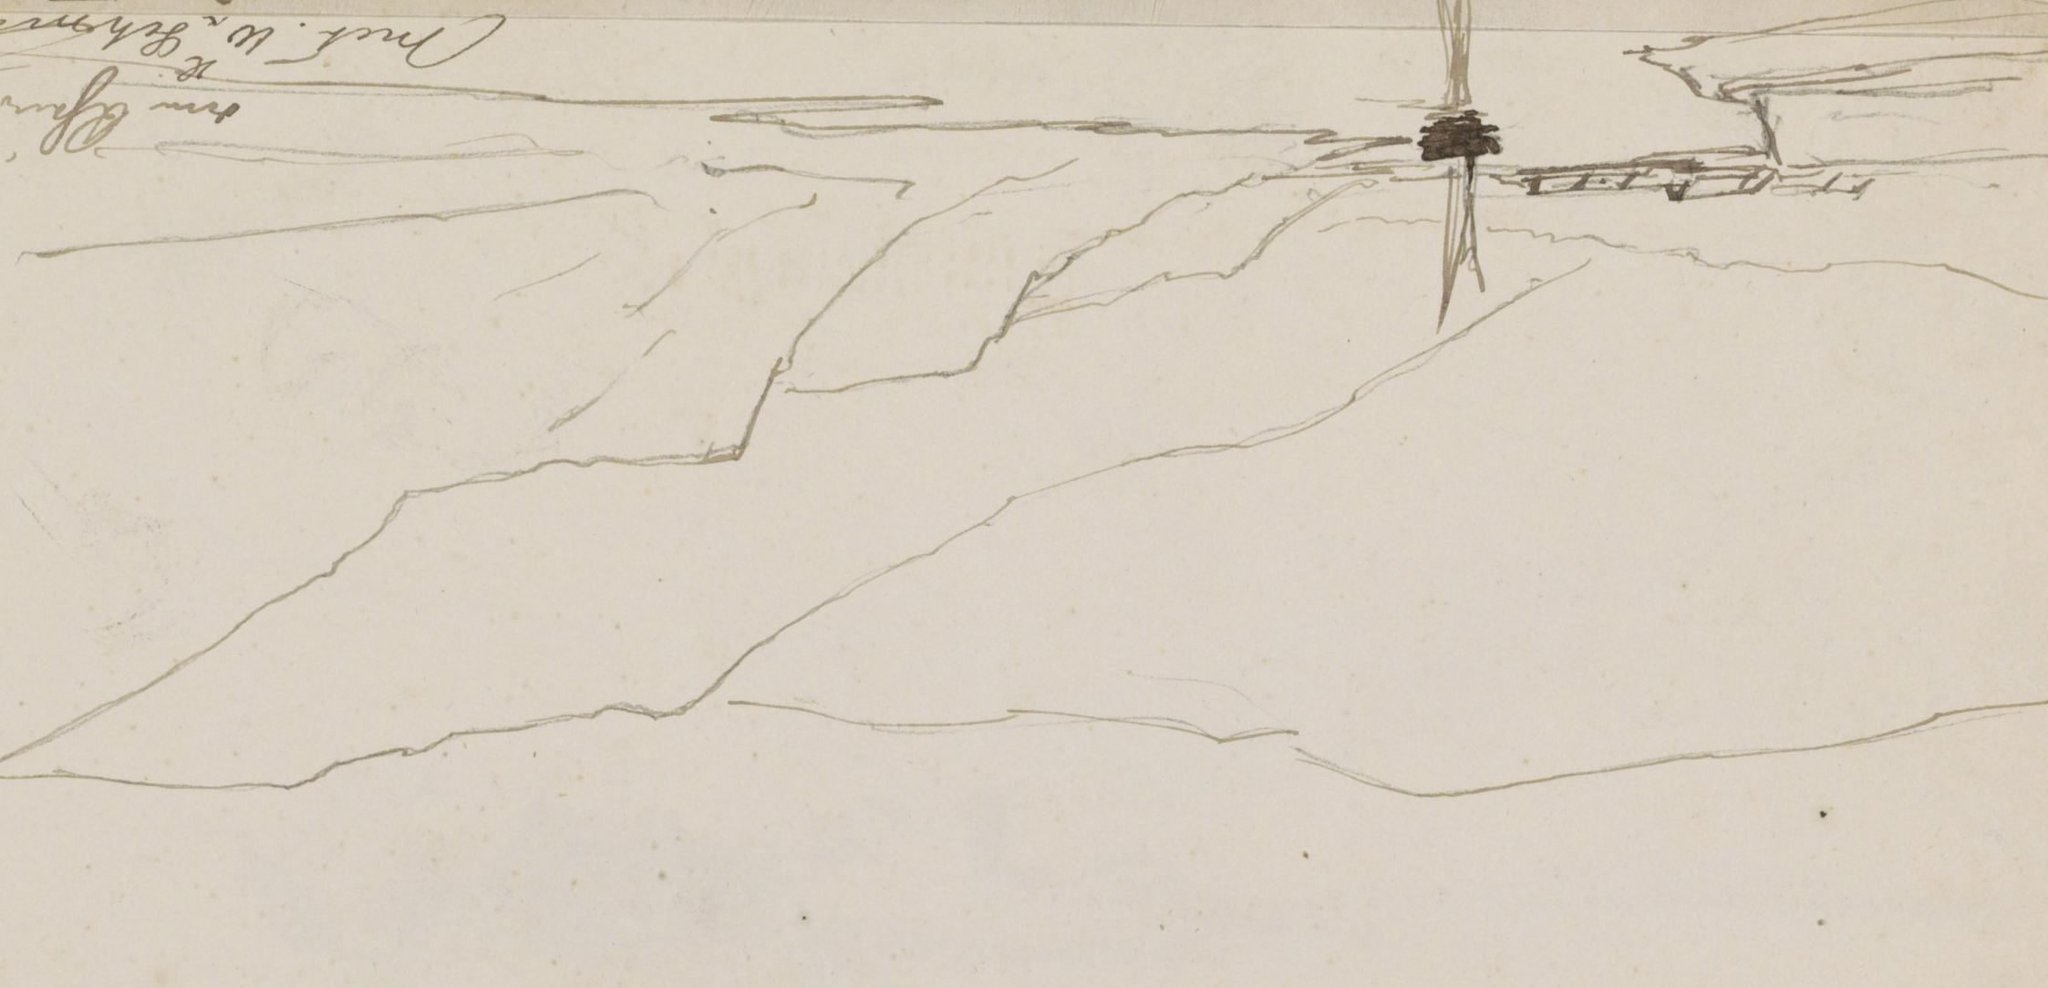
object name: sketchbook leaf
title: Berglandschap met een zeilschip op een meer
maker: johannes tavenraat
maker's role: draughtsman, painter, print maker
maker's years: 1809-1881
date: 1840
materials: ink, paper, pencil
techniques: pen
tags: sailing-ship, sailing-boat, landscapes with waters, waterscapes, seascapes (in the temperate zone), mountains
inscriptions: date and inscription: ‘den R[..]n 1840/ met W.H. Schmidt.’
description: Blad 34 recto uit een schetsboek met 63 bladen.